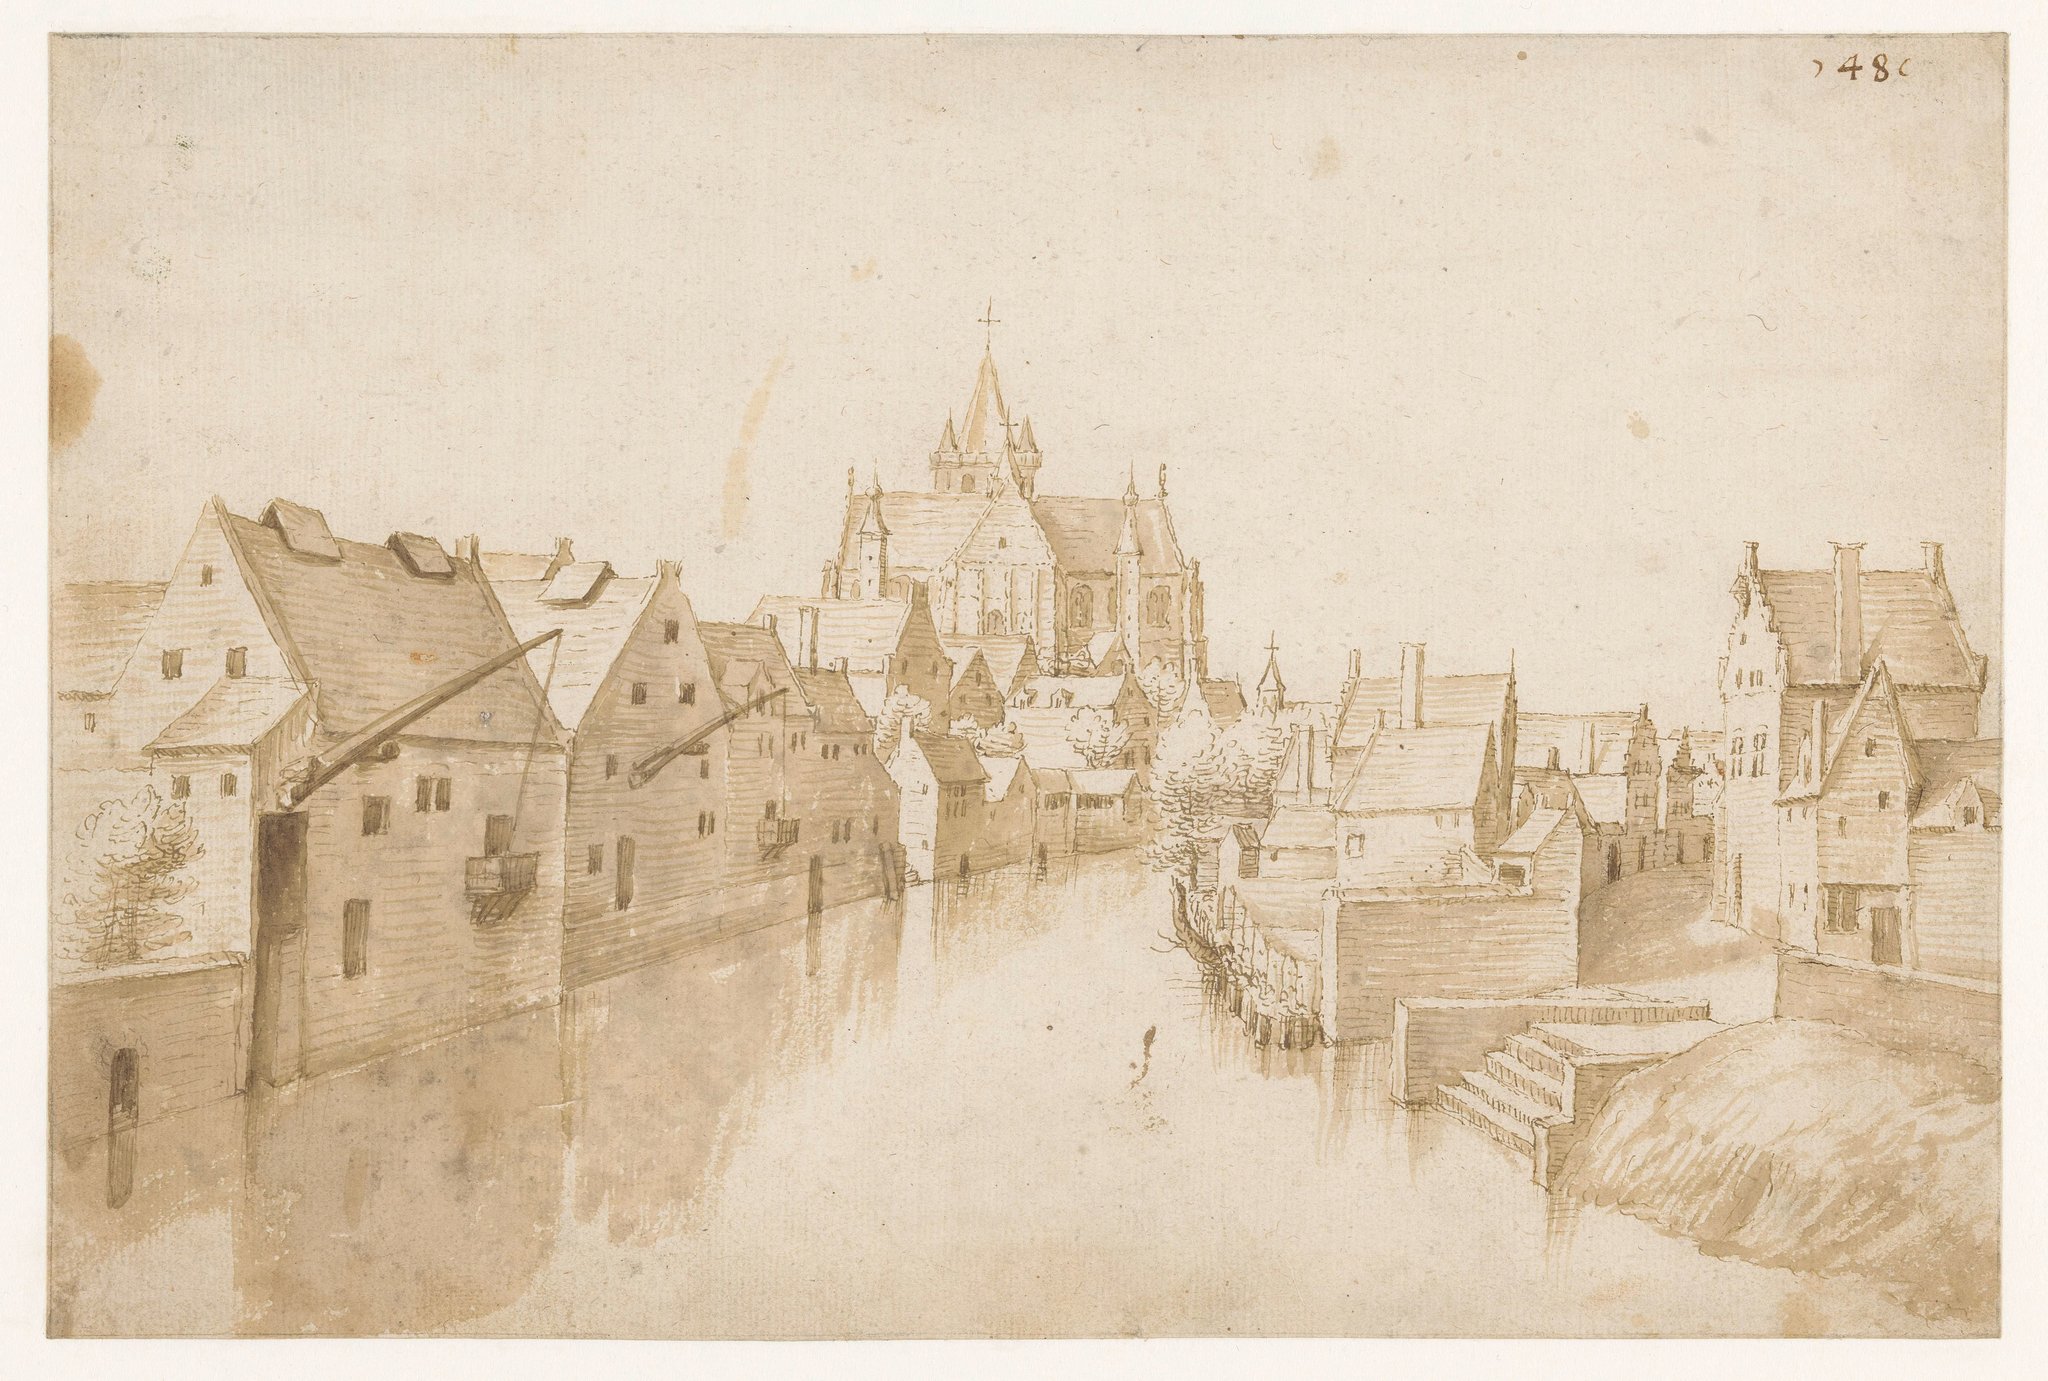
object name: drawing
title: De kerk van Onze-Lieve-Vrouw-over-de-Dijle, te Mechelen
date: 1600-1699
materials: ink, paper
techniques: brush, pen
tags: church (exterior), public road